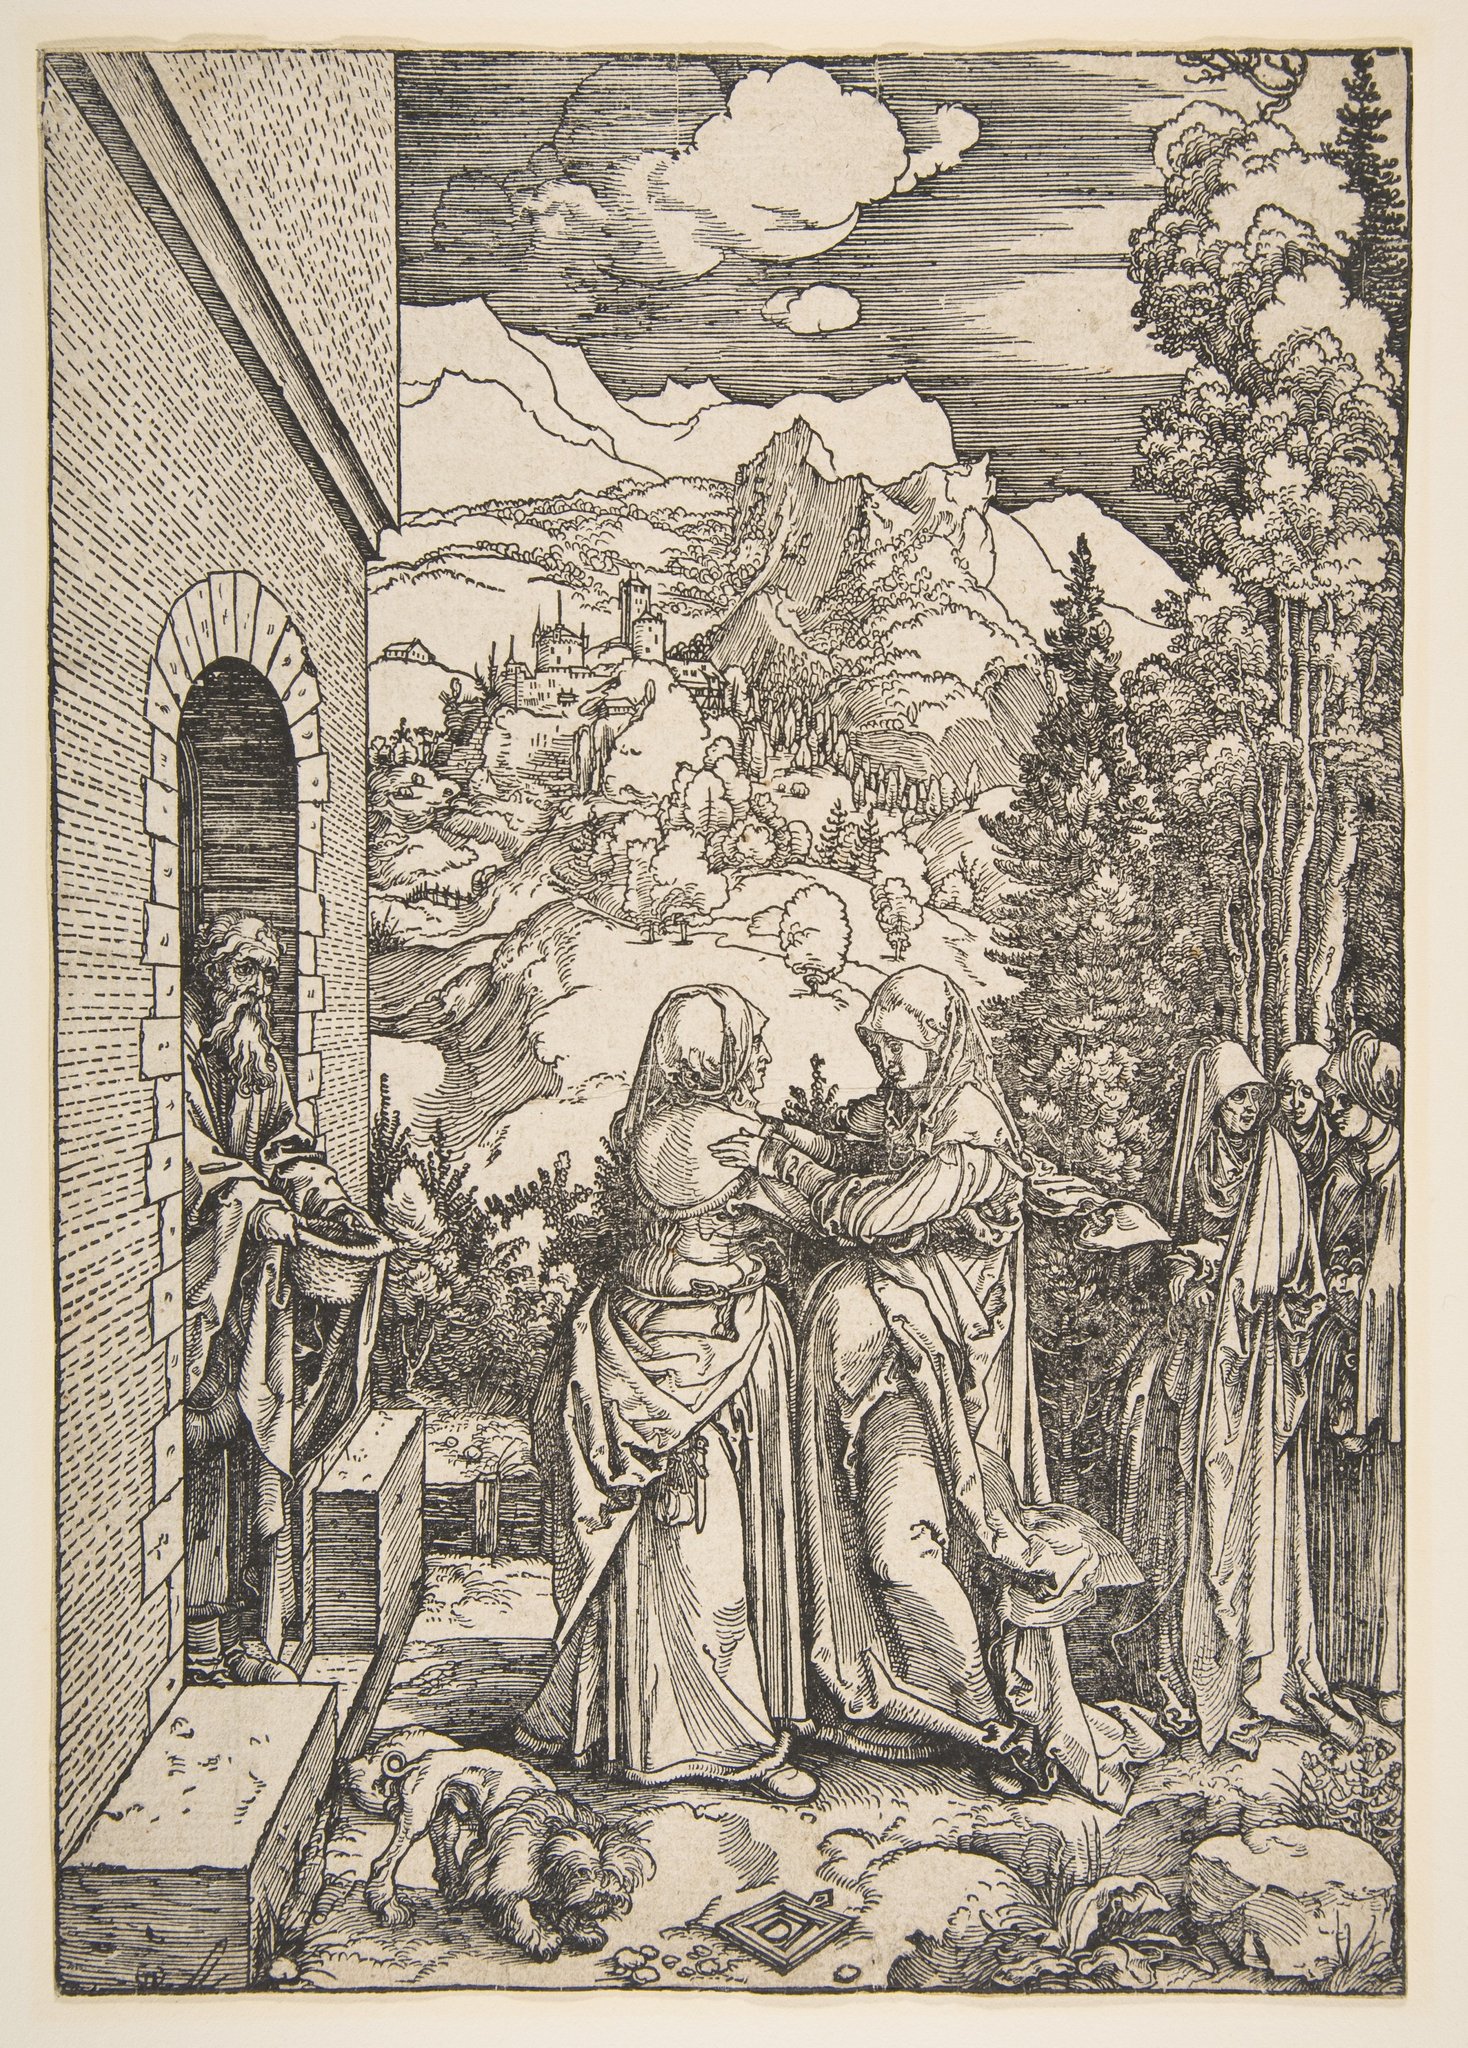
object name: print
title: The Visitation, from "The Life of the Virgin"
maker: albrecht dürer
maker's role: artist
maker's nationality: german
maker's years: 1471-1528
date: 1503-1504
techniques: woodcut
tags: men,women,dogs,trees,virgin mary